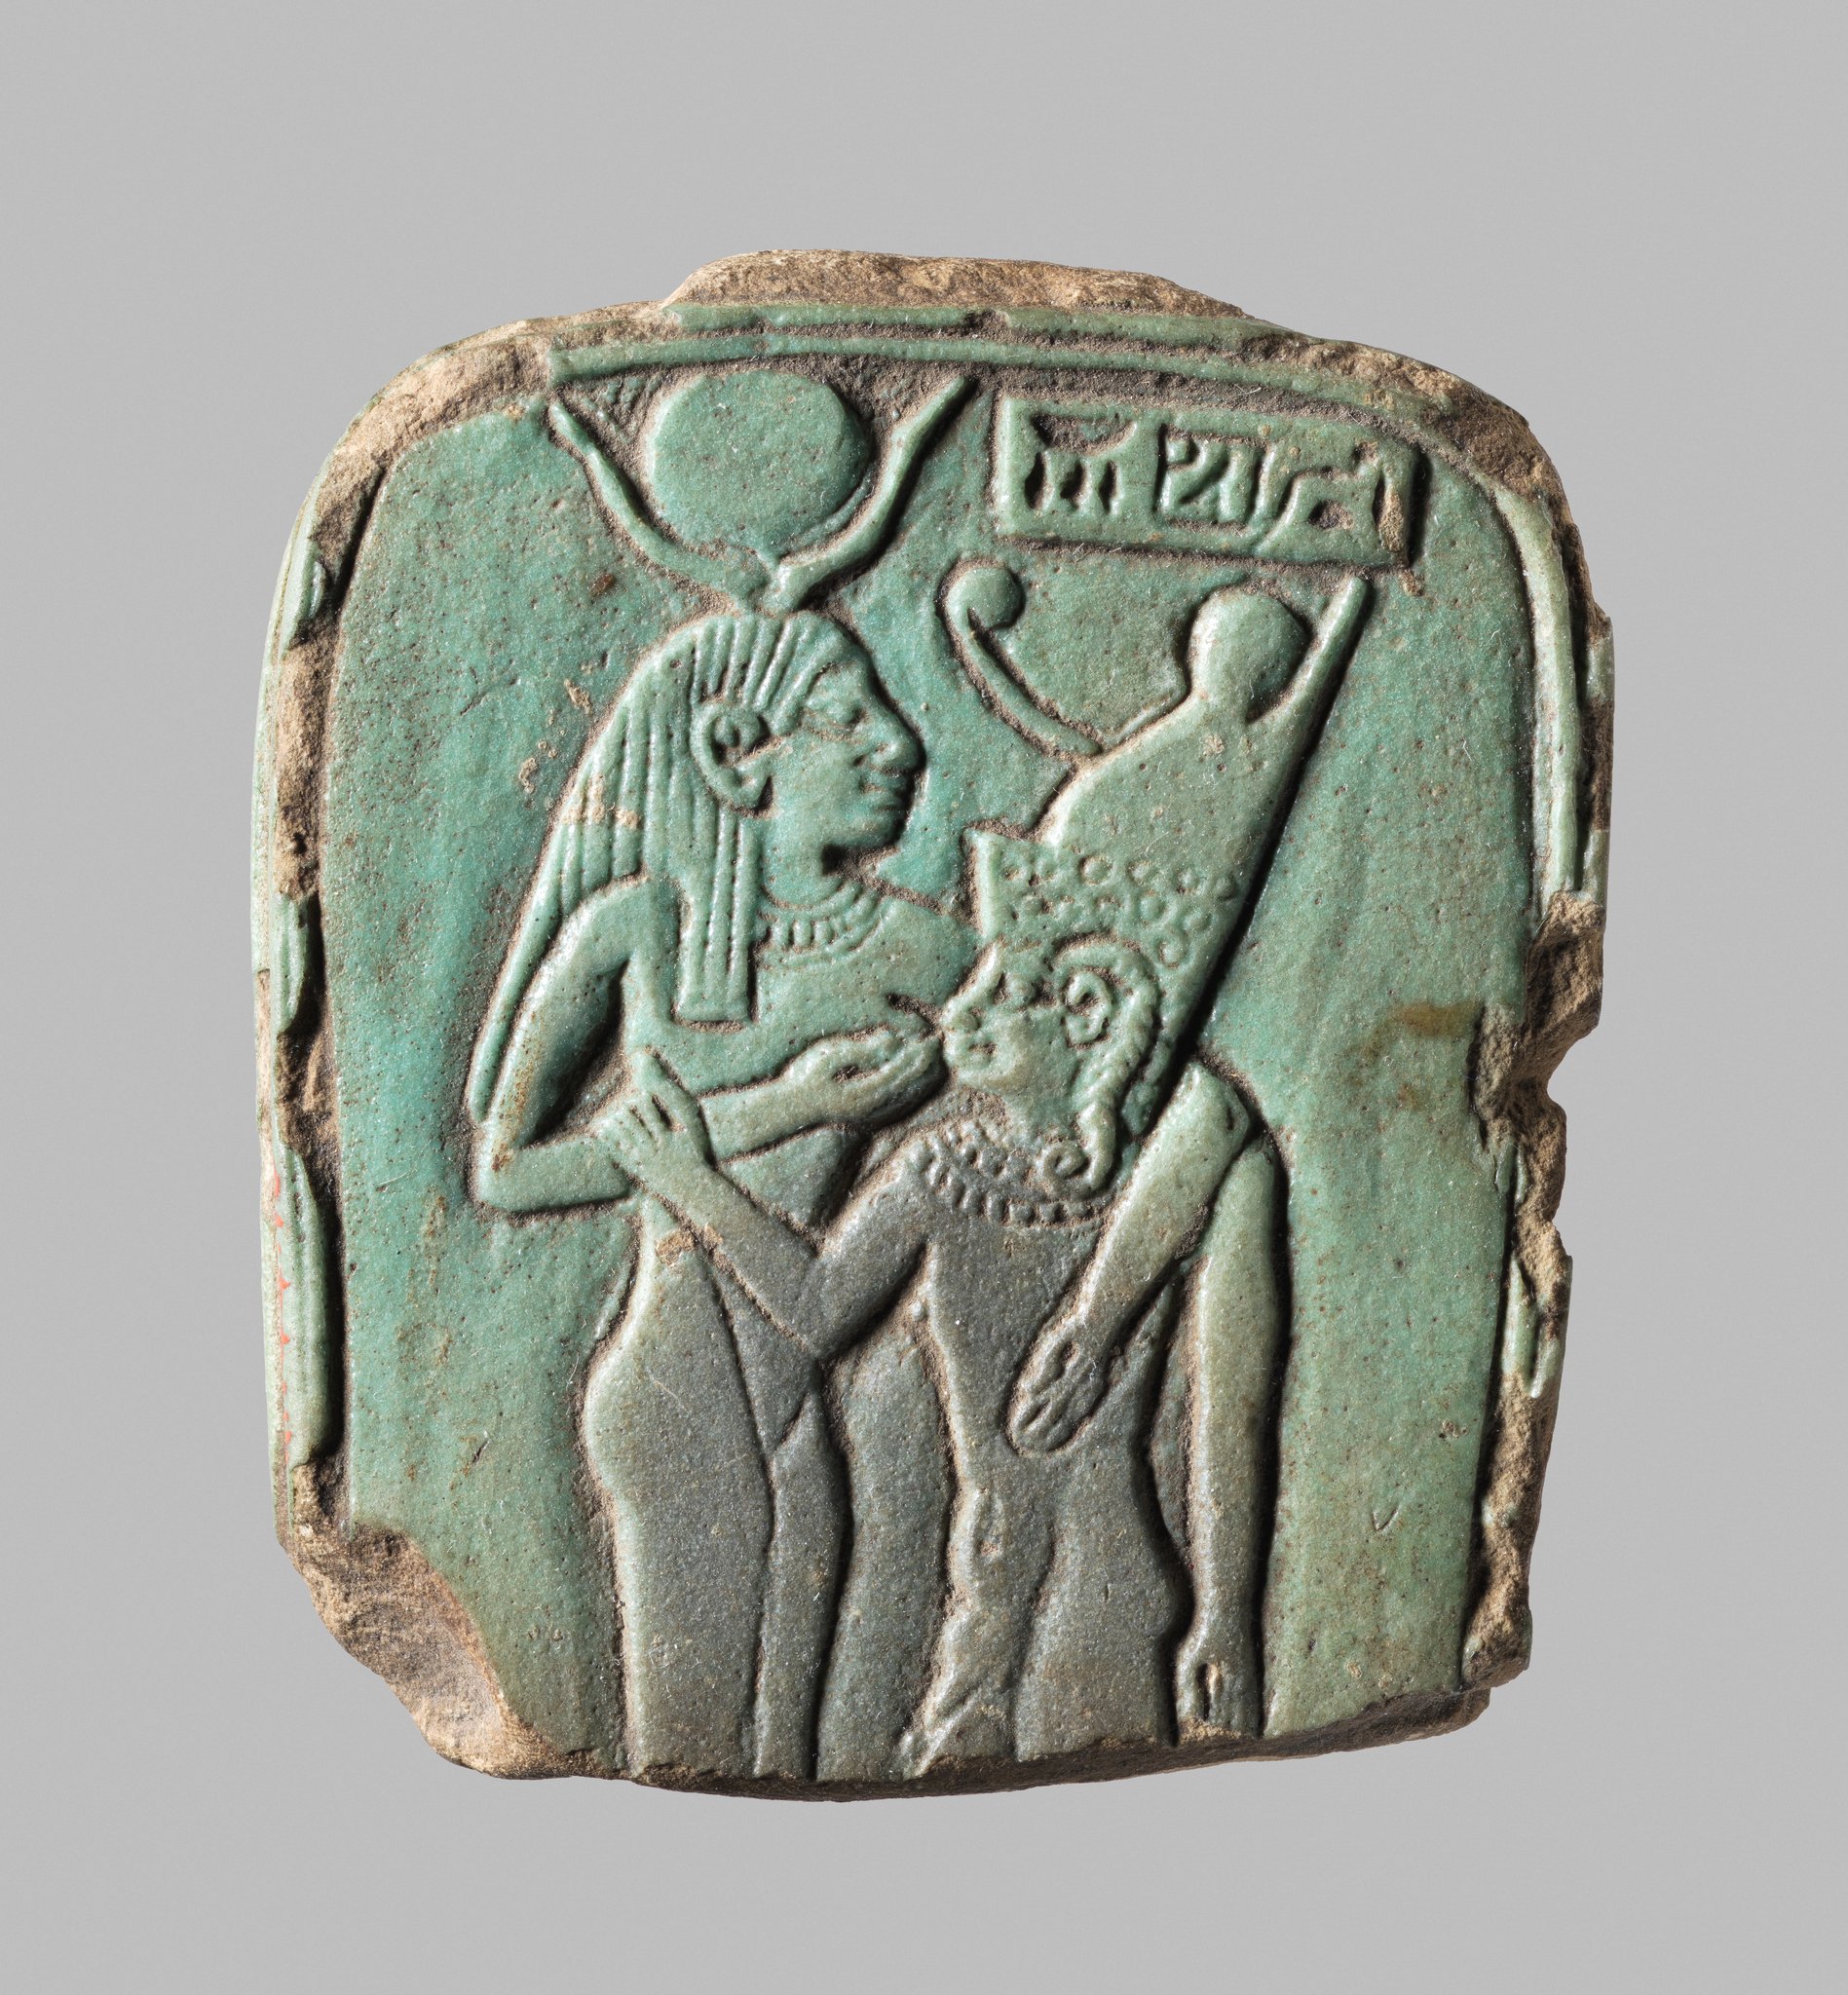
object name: menat fragment, goddess, king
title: Menat fragment showing goddess nursing king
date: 1070-664 BCE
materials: faience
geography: egypt